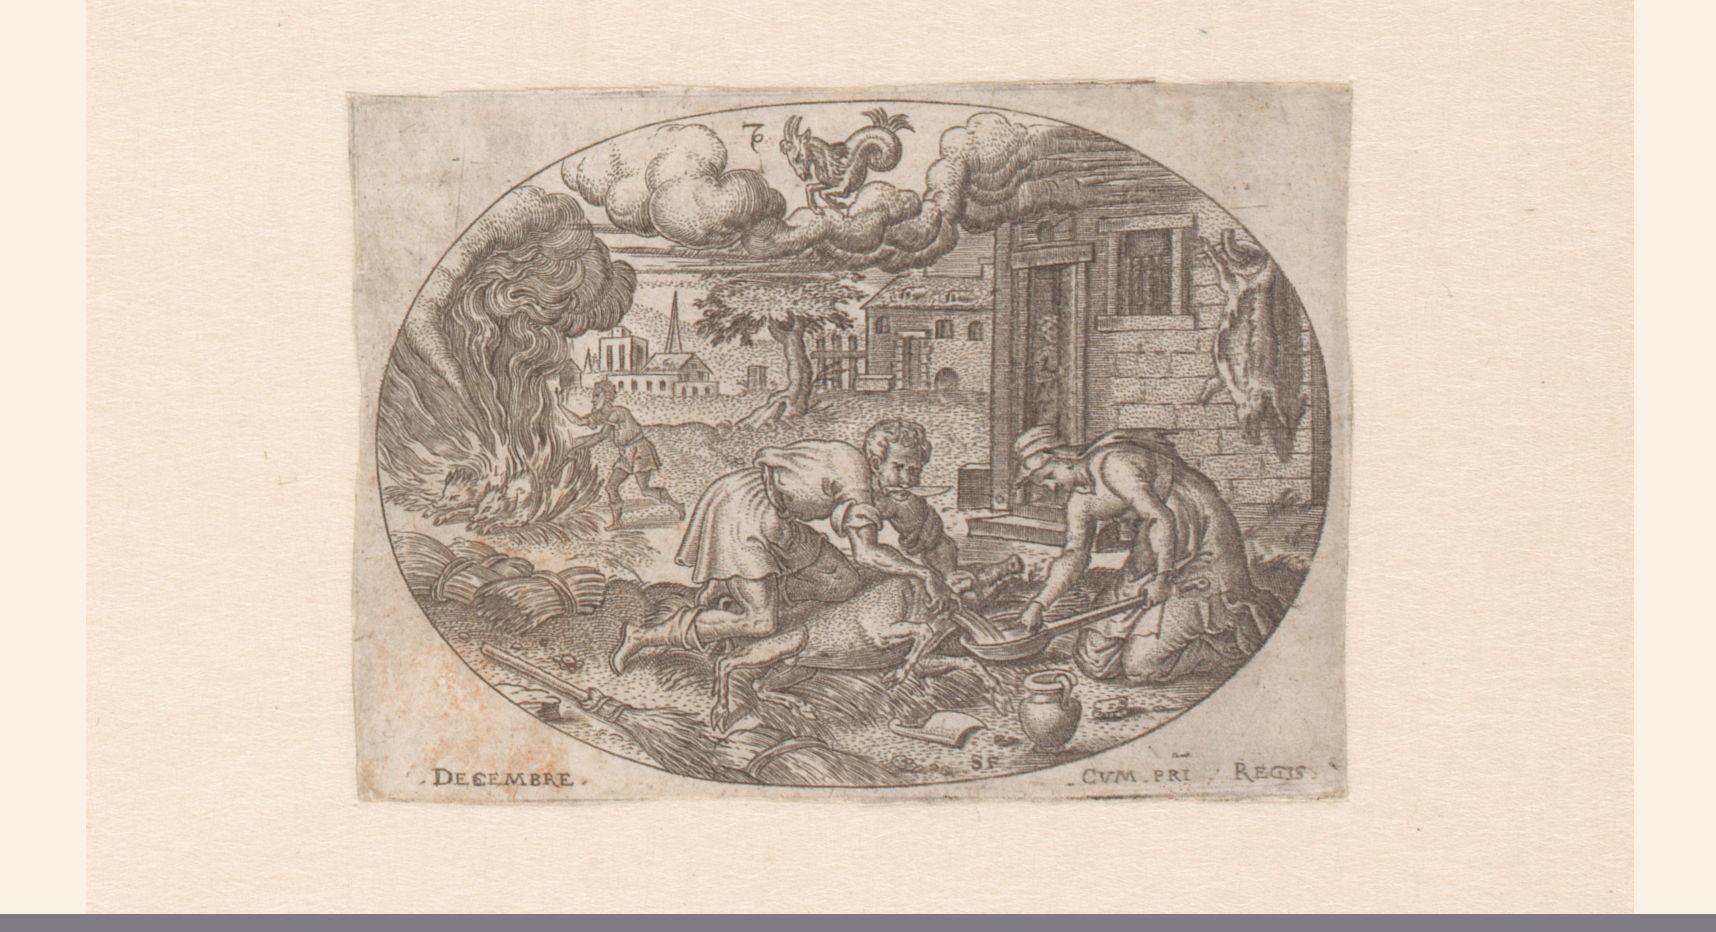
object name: print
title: Oktober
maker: etienne delaune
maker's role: draughtsman, goldsmith, print maker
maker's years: 1519-1583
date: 1568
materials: paper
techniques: engraving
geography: france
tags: libra (zodiacal sign of september), october and its 'labours' (+ with zodiacal signs)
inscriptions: collector's mark: Lugt 240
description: Maakt deel uit van een twaalfdelige serie van de twaalf maanden met tekens van de dierenriem, in ovale vorm. In de collectie van het Rijksmuseum bevindt zich de complete serie.